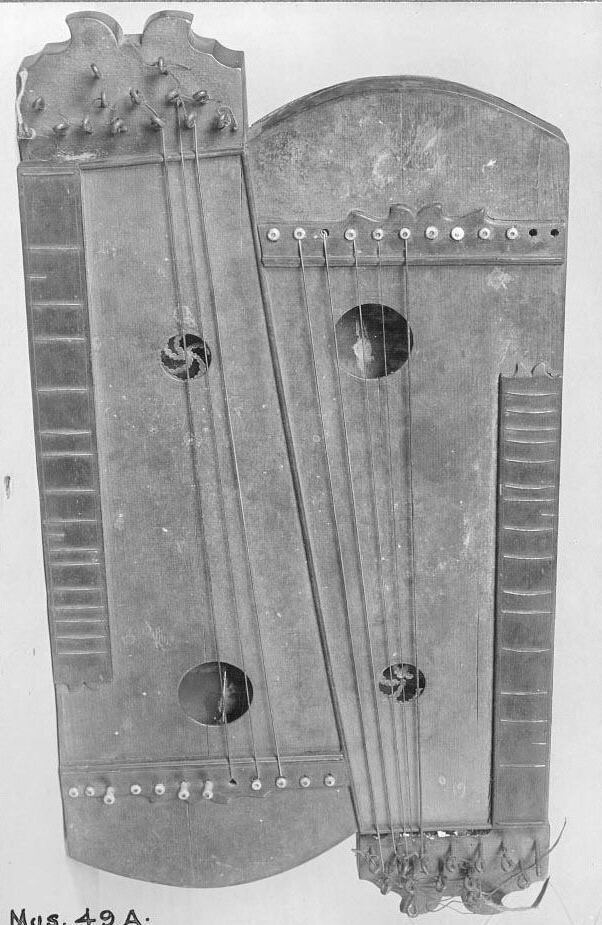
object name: double zither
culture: german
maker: andreas giller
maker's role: maker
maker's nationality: german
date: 1701-1800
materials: metal, wood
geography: germany